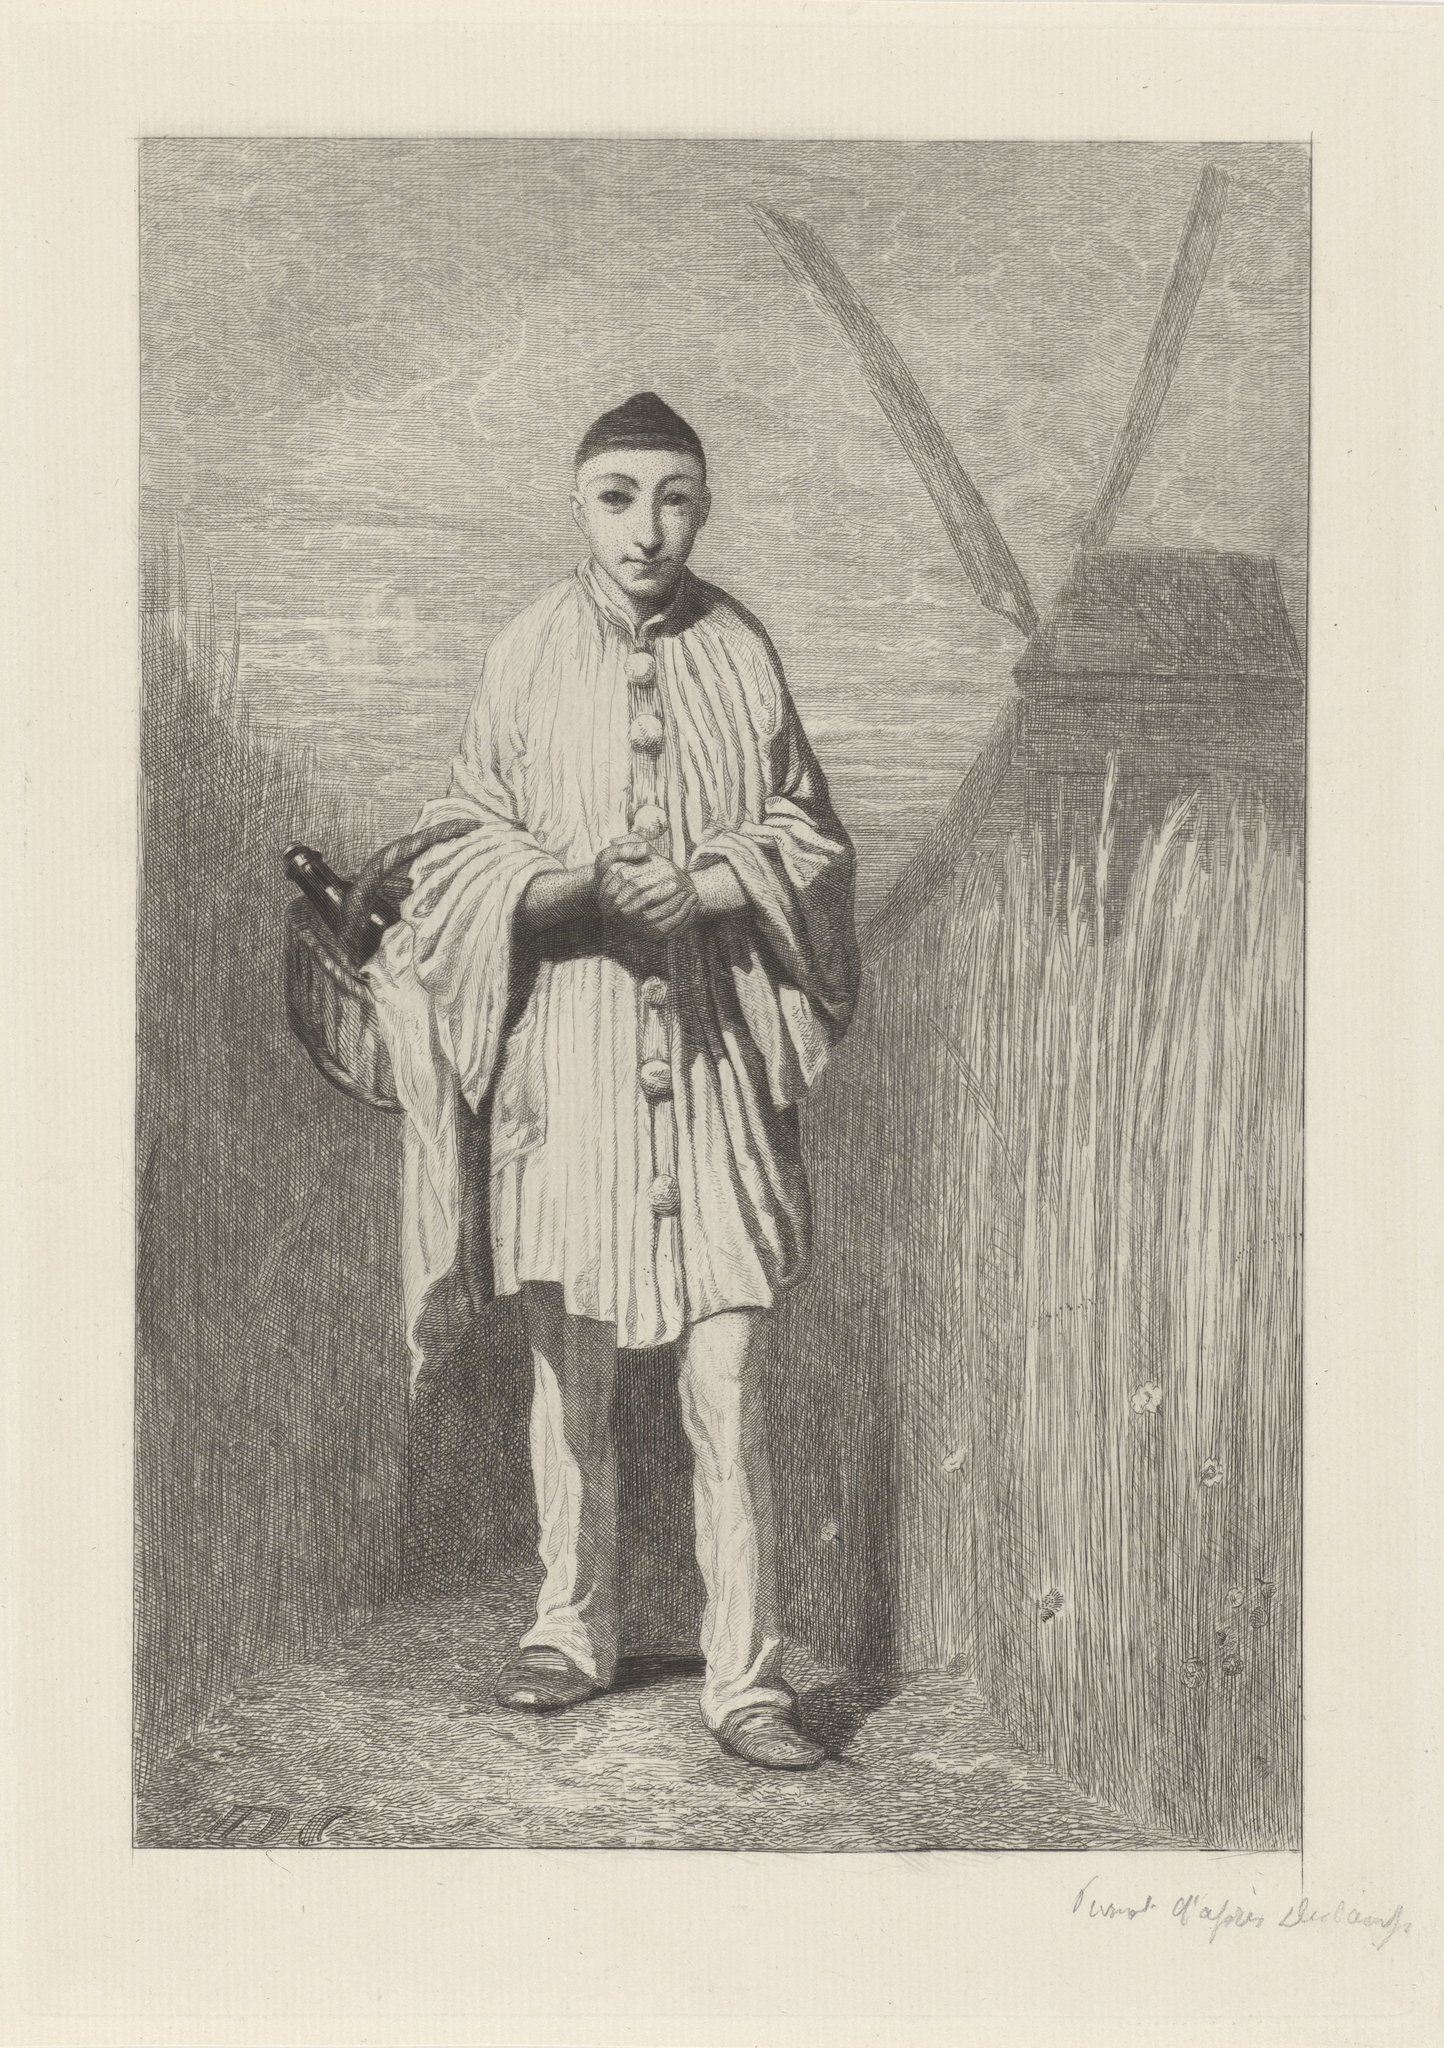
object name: print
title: Pierrot bij een molen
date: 1851-1893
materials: paper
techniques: etching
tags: types in 'commedia dell'arte': pierrot, carrying something in basket, bag, rucksack, etc., windmill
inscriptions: collector's mark: Lugt 2228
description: Een pierrot, ten voeten uit, met een hengselmand aan zijn arm. Rechts op de achtergrond een molen.